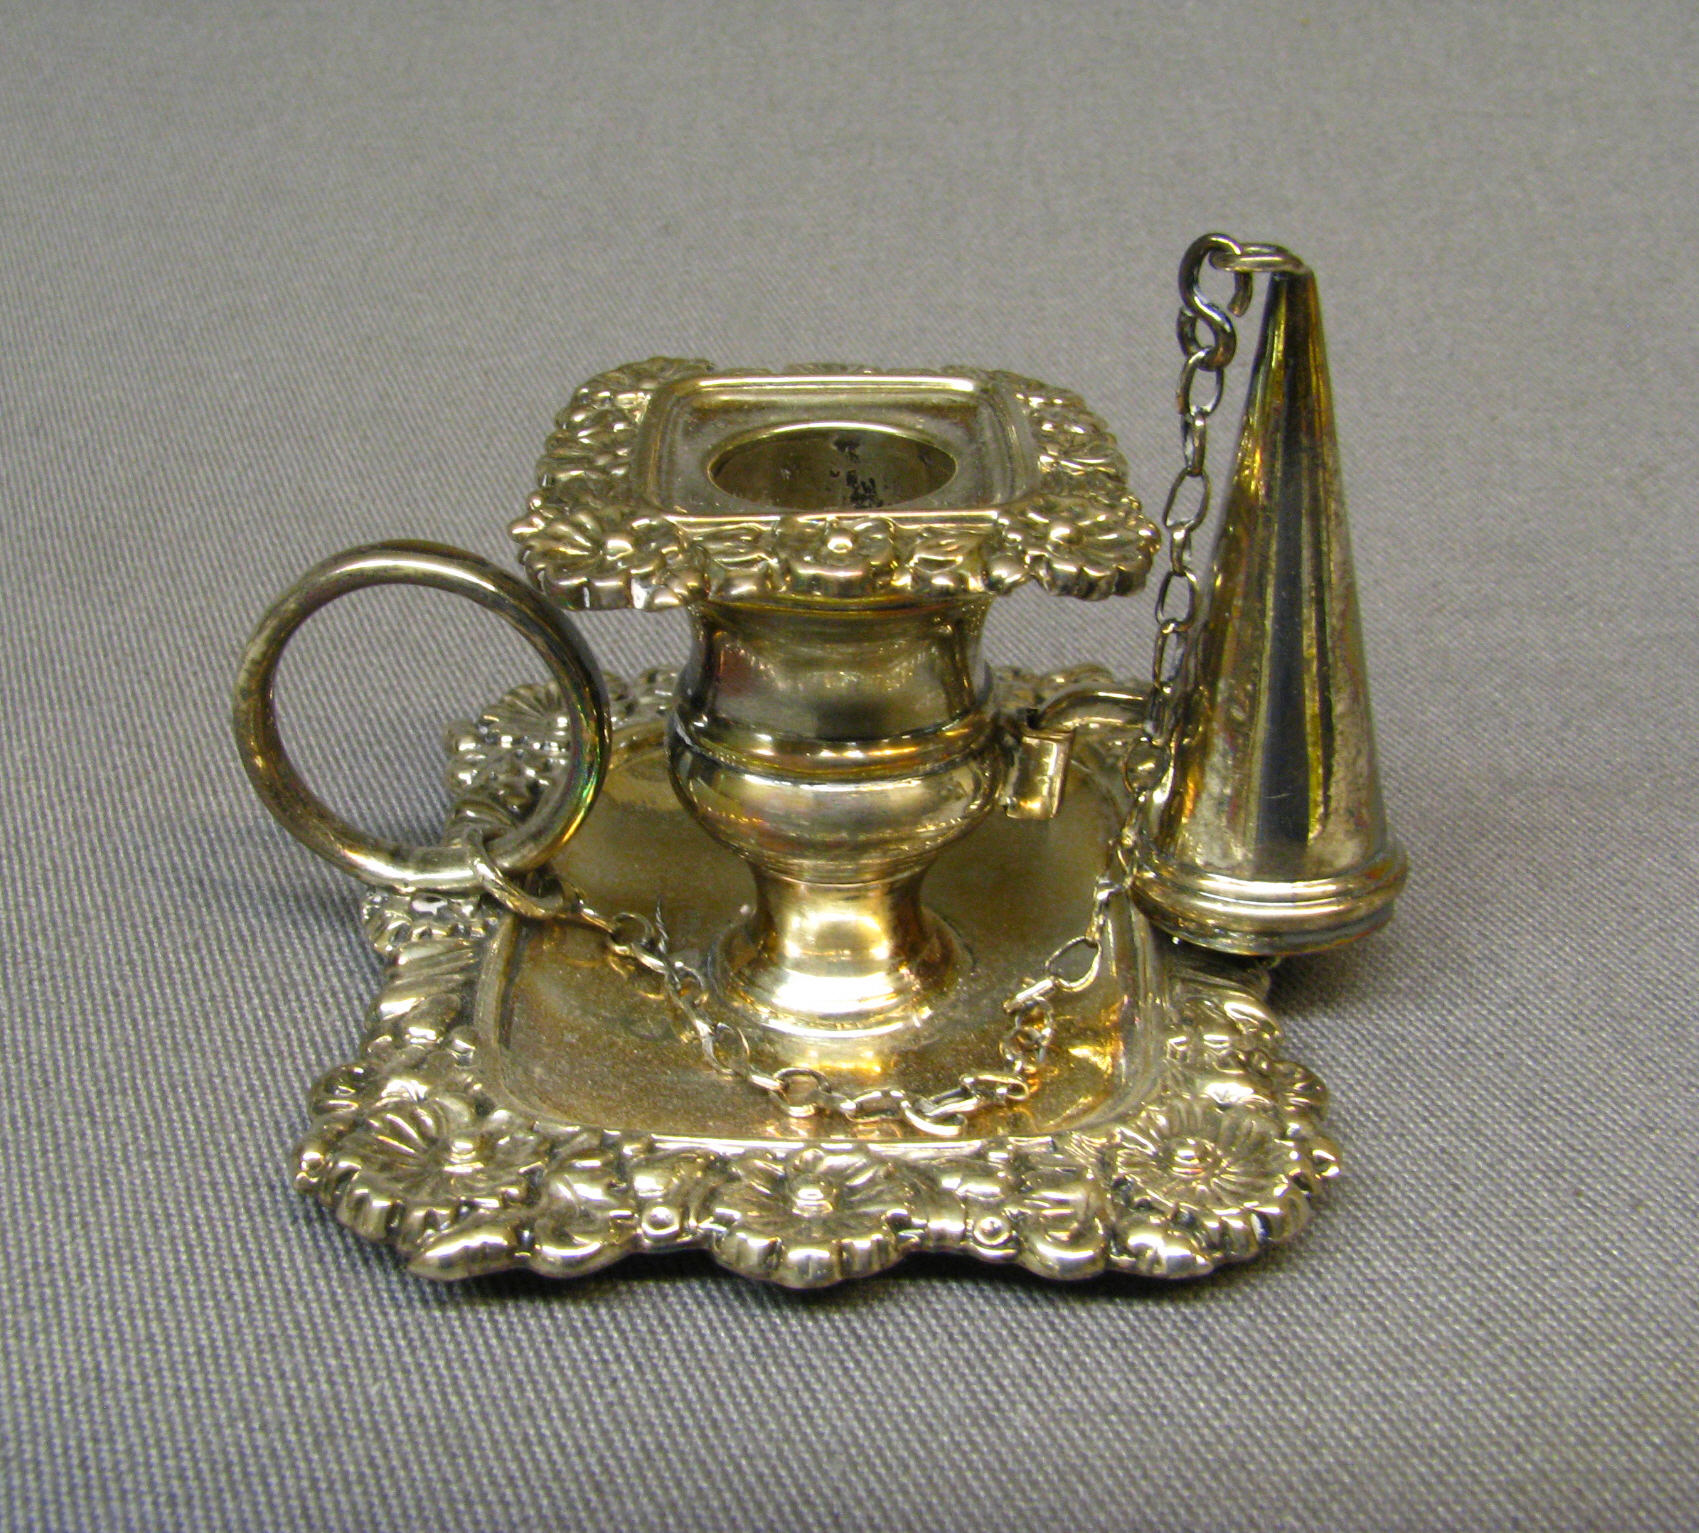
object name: chamber candlestick or taperstick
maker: john & thomas settle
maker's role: maker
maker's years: 1800-1825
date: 1822-1823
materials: silver